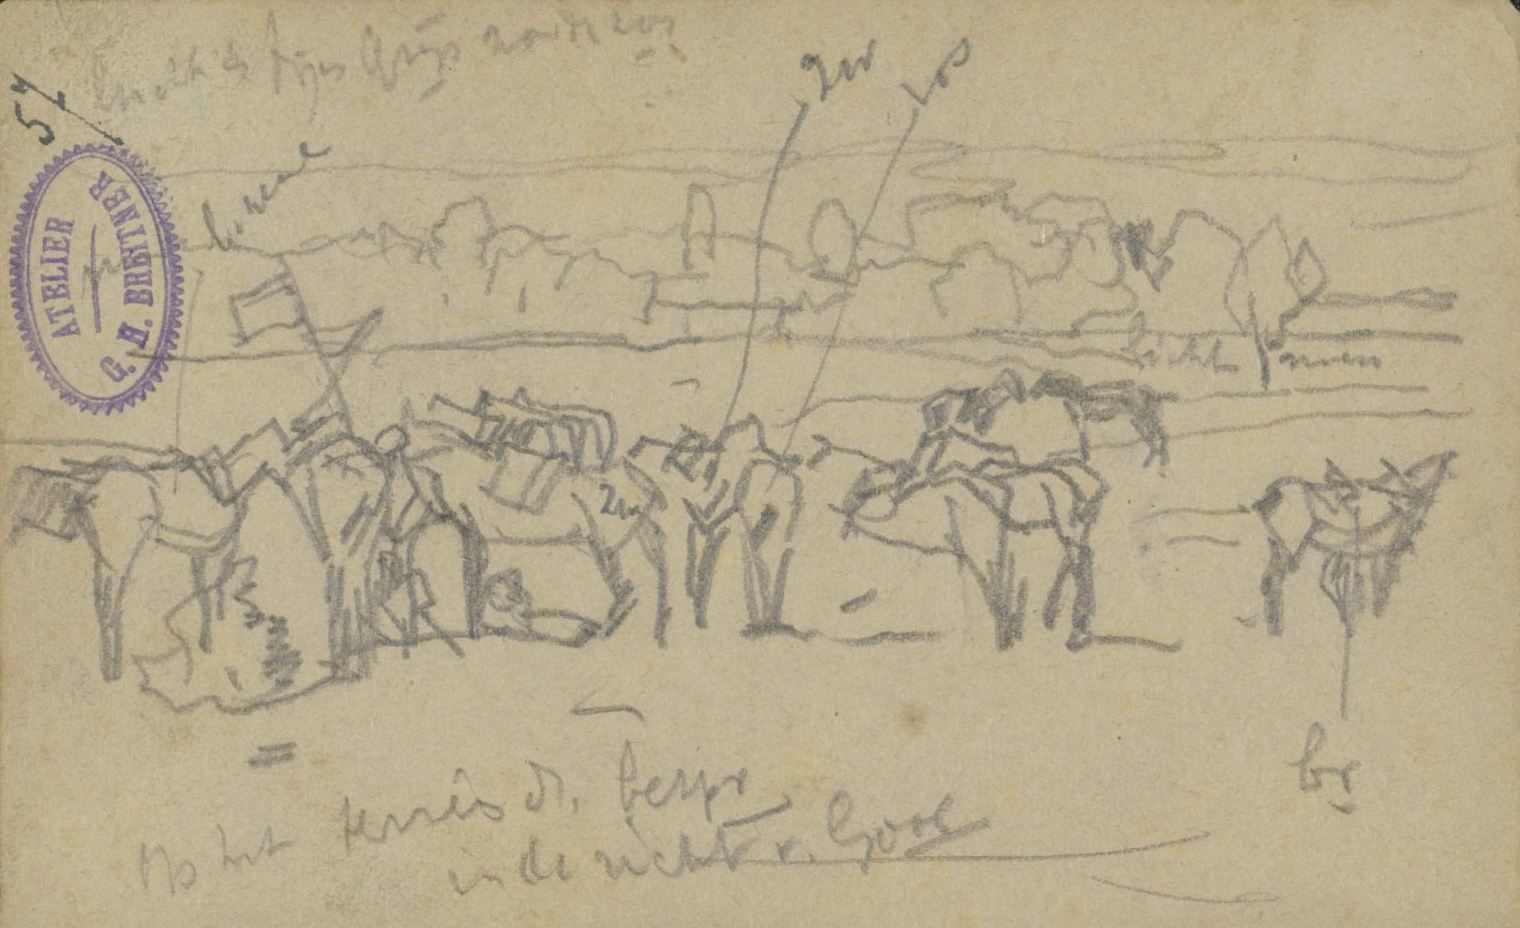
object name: drawing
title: Rustende paarden op een manoeuvreterrein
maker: george hendrik breitner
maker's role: draughtsman, painter, print maker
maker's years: 1857-1923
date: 1887-1891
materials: paper, pencil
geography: gelderland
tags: manoeuvre ~ military training, landscapes in the temperate zone, horse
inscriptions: workshop stamp: Lugt 291d, annotation: ‘op het terrein de bespr./ in de richt v. Goos[?]’